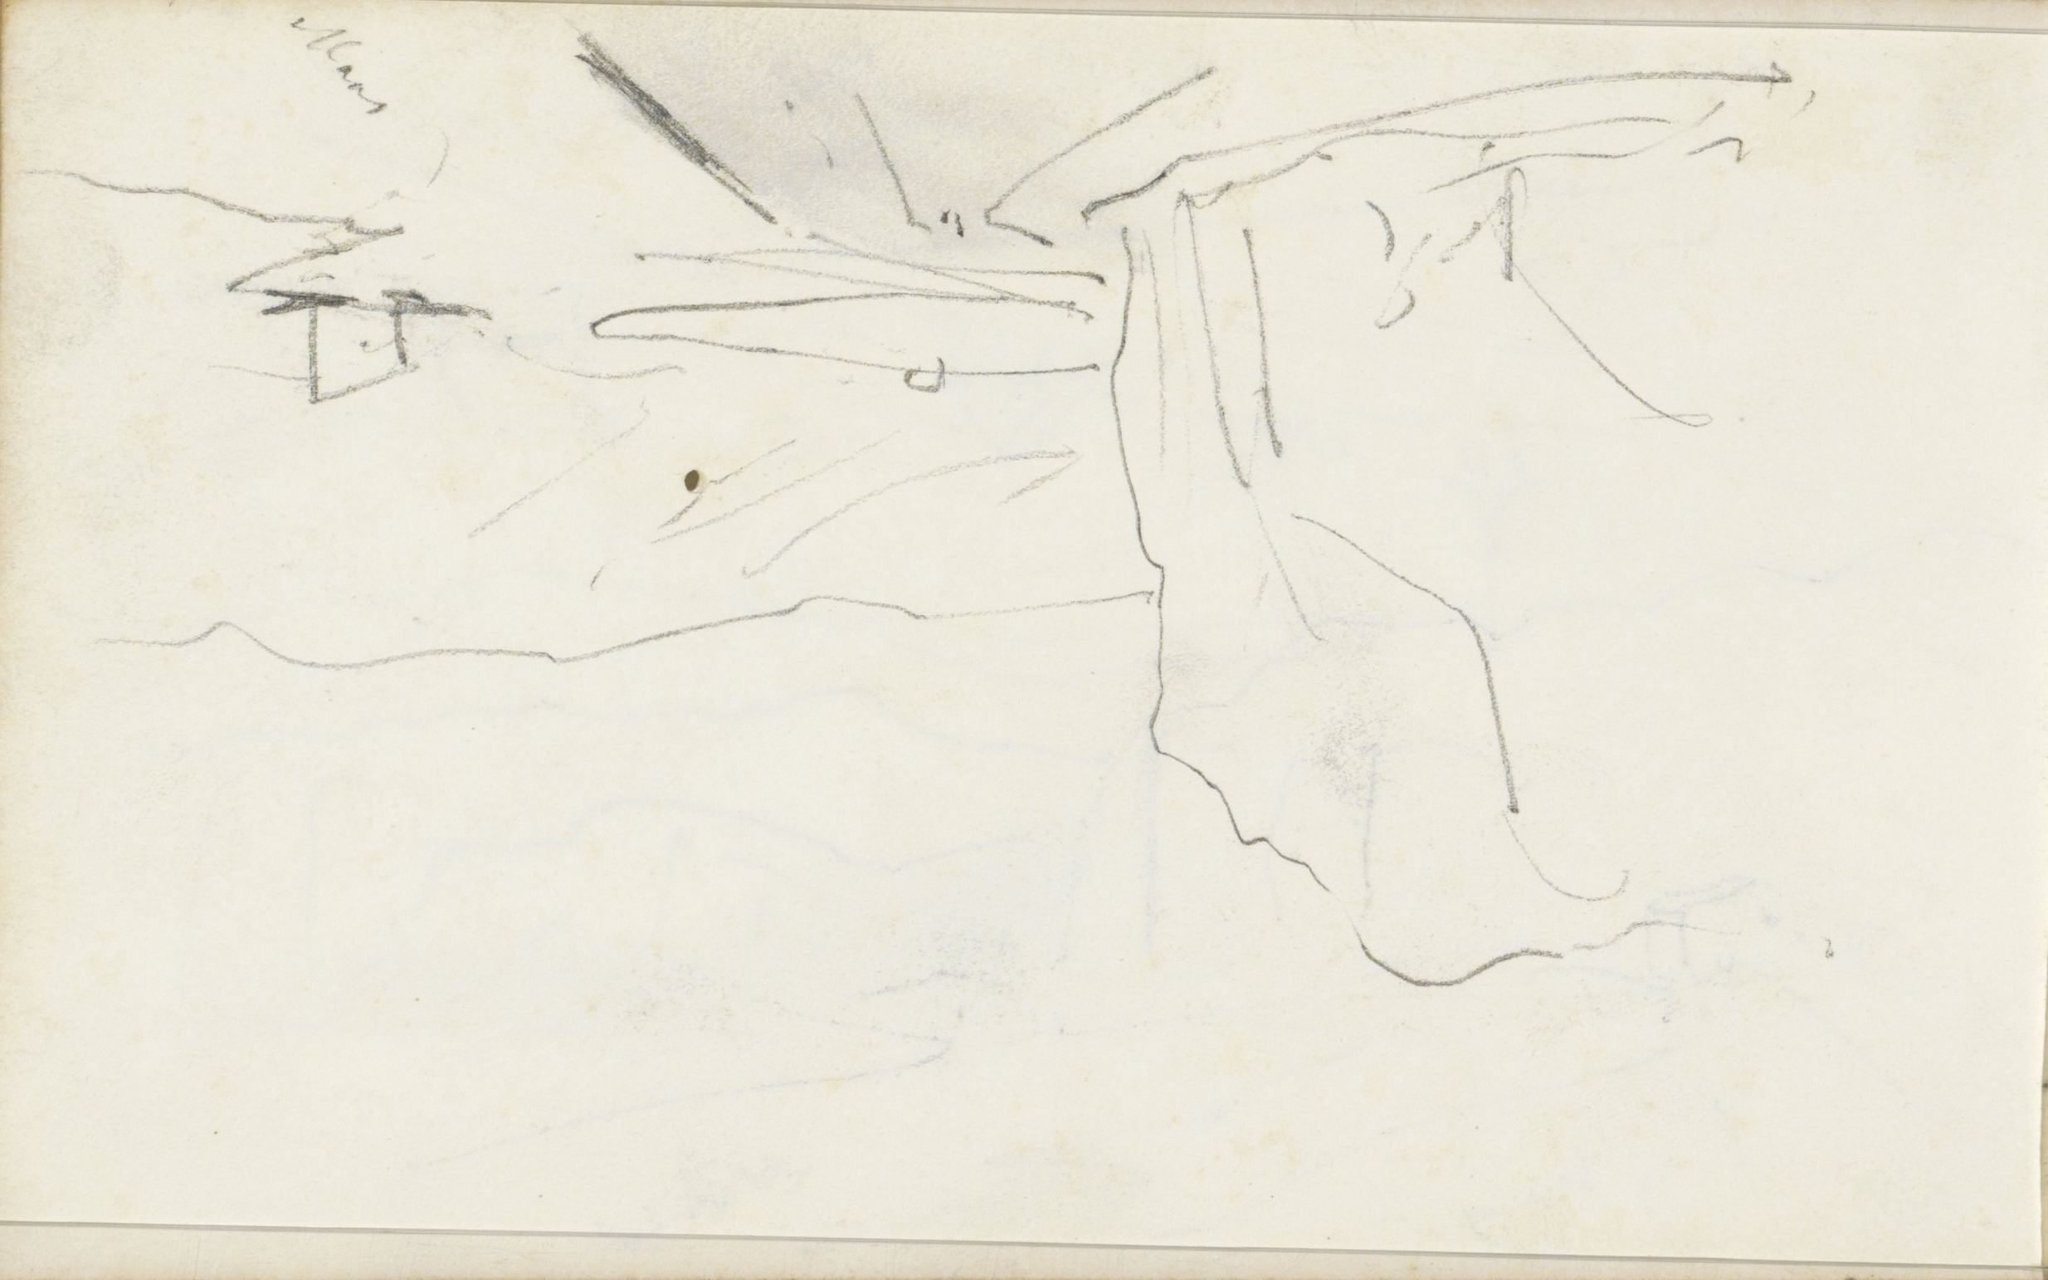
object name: sketchbook leaf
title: Pad tussen de bergen aan de Maas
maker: johannes tavenraat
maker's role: draughtsman, painter, print maker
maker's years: 1809-1881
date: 1840-1841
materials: paper, pencil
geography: meuse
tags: city-view, and landscape with man-made constructions, landscapes with waters, waterscapes, seascapes (in the temperate zone), road, path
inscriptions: annotation: ‘Maas’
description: Blad 21 verso uit een schetsboek met 41 bladen.